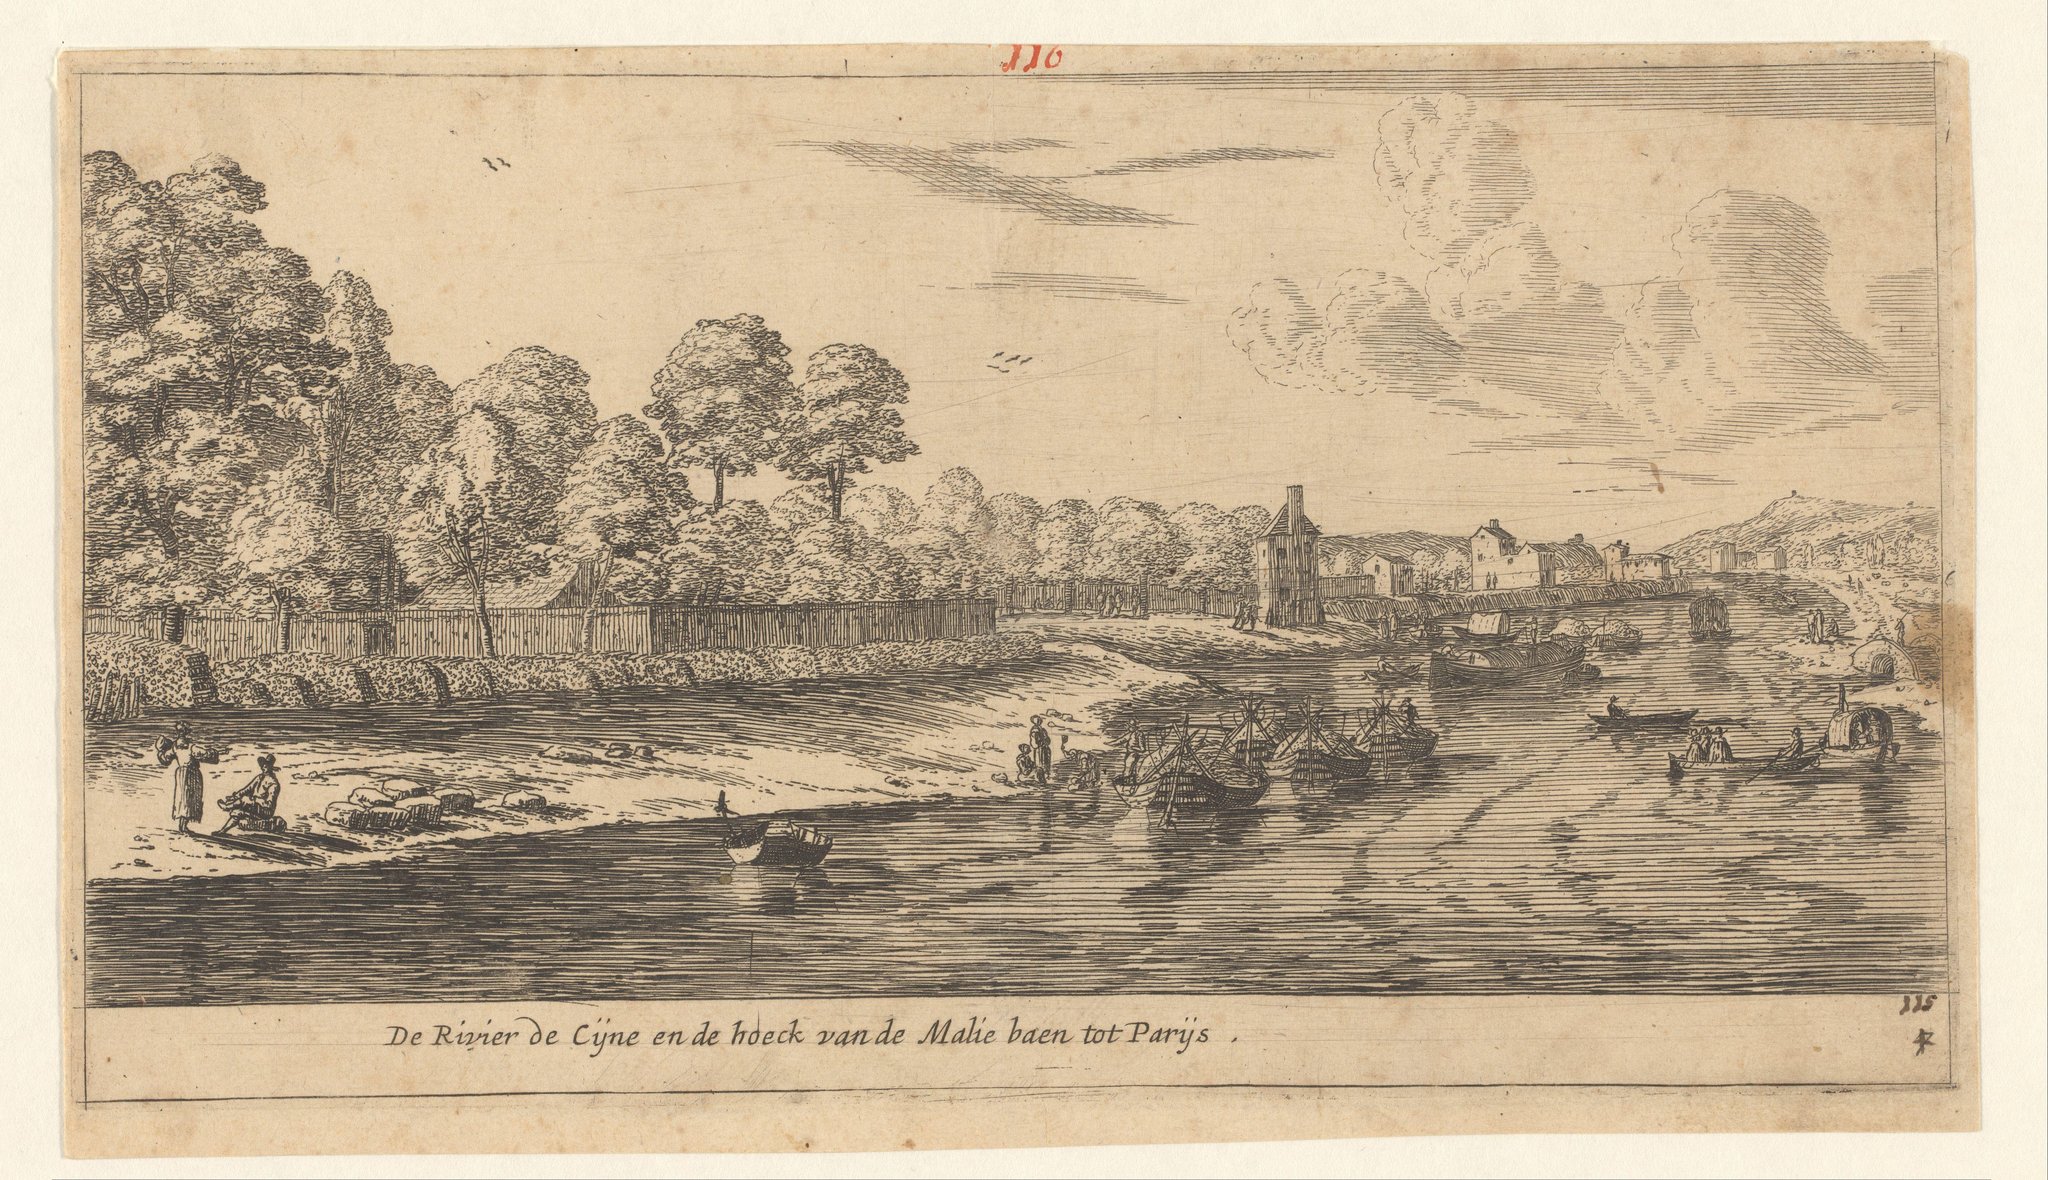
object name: print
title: Gezichten op Parijs en omgeving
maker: reinier nooms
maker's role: draughtsman, painter, print maker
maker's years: 1623-1664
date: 1656-1662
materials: paper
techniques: drypoint, etching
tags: outskirts of city, paris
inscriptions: collector's mark: Lugt 2228